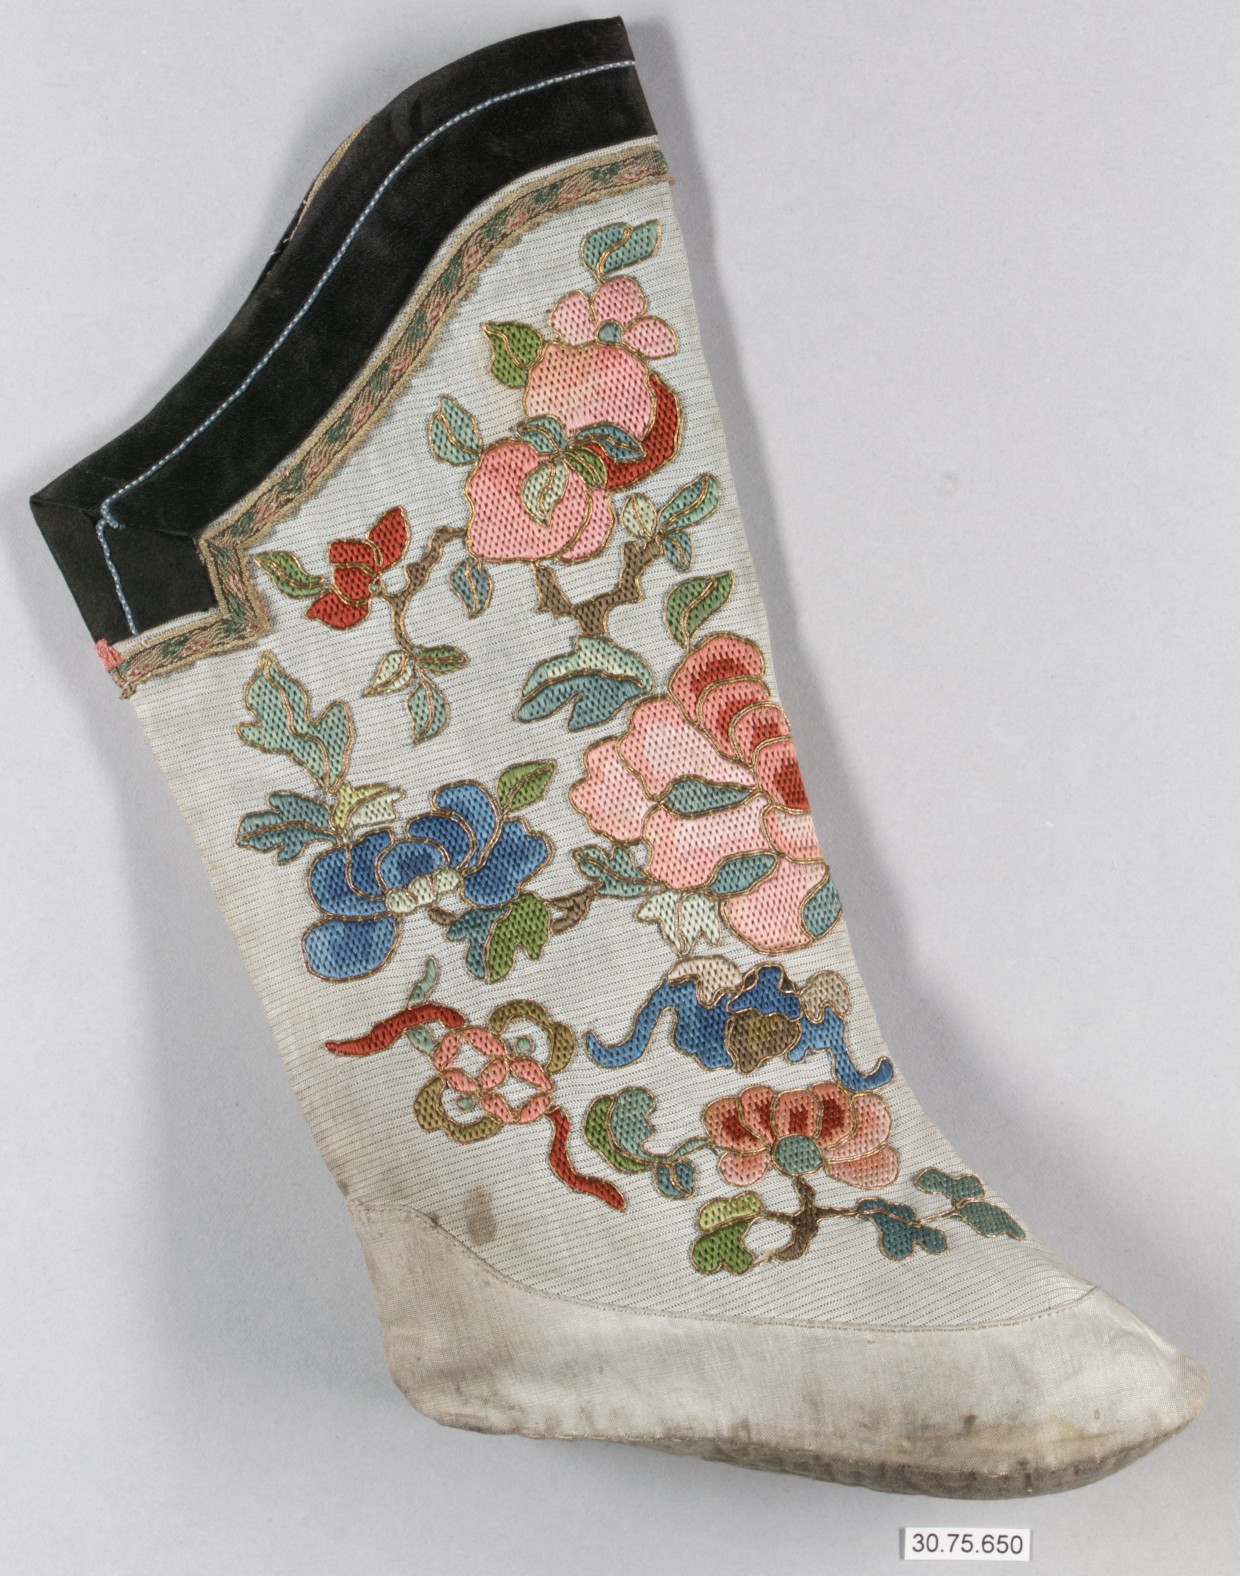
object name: boot, child's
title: Child's Boot (one of a pair)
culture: chinese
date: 1701-1900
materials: silk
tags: flowers